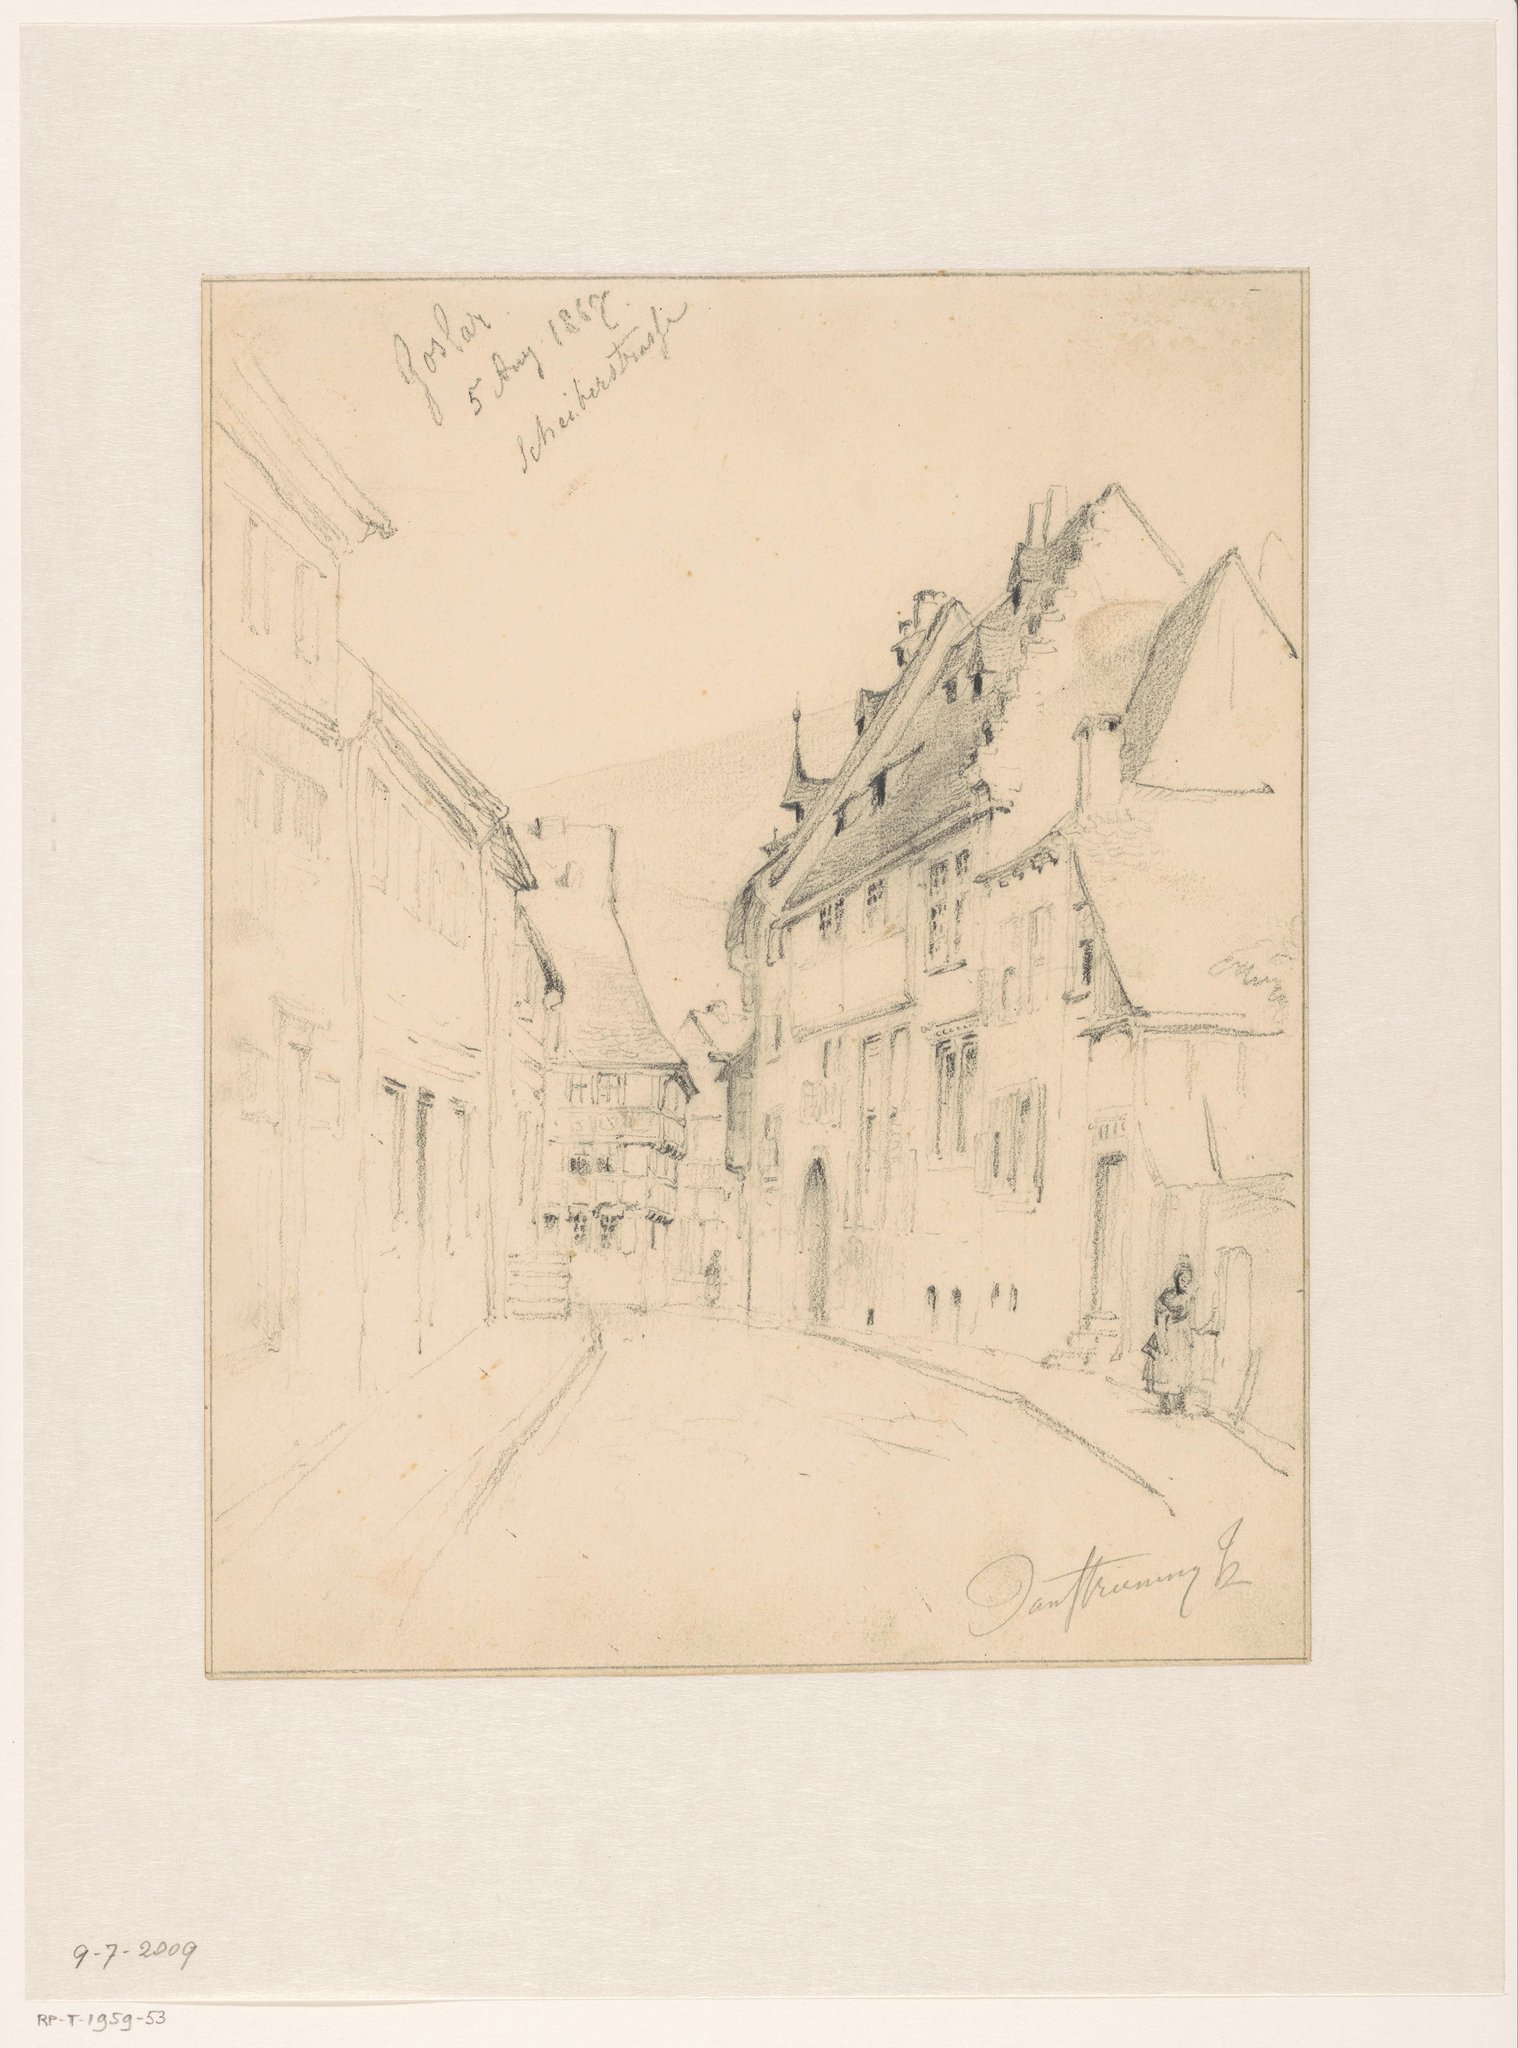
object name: drawing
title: Gezicht op de Scheiberstrasze te Goslar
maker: jan striening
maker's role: draughtsman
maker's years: 1827-1903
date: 1867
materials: paper, pencil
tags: street, germany